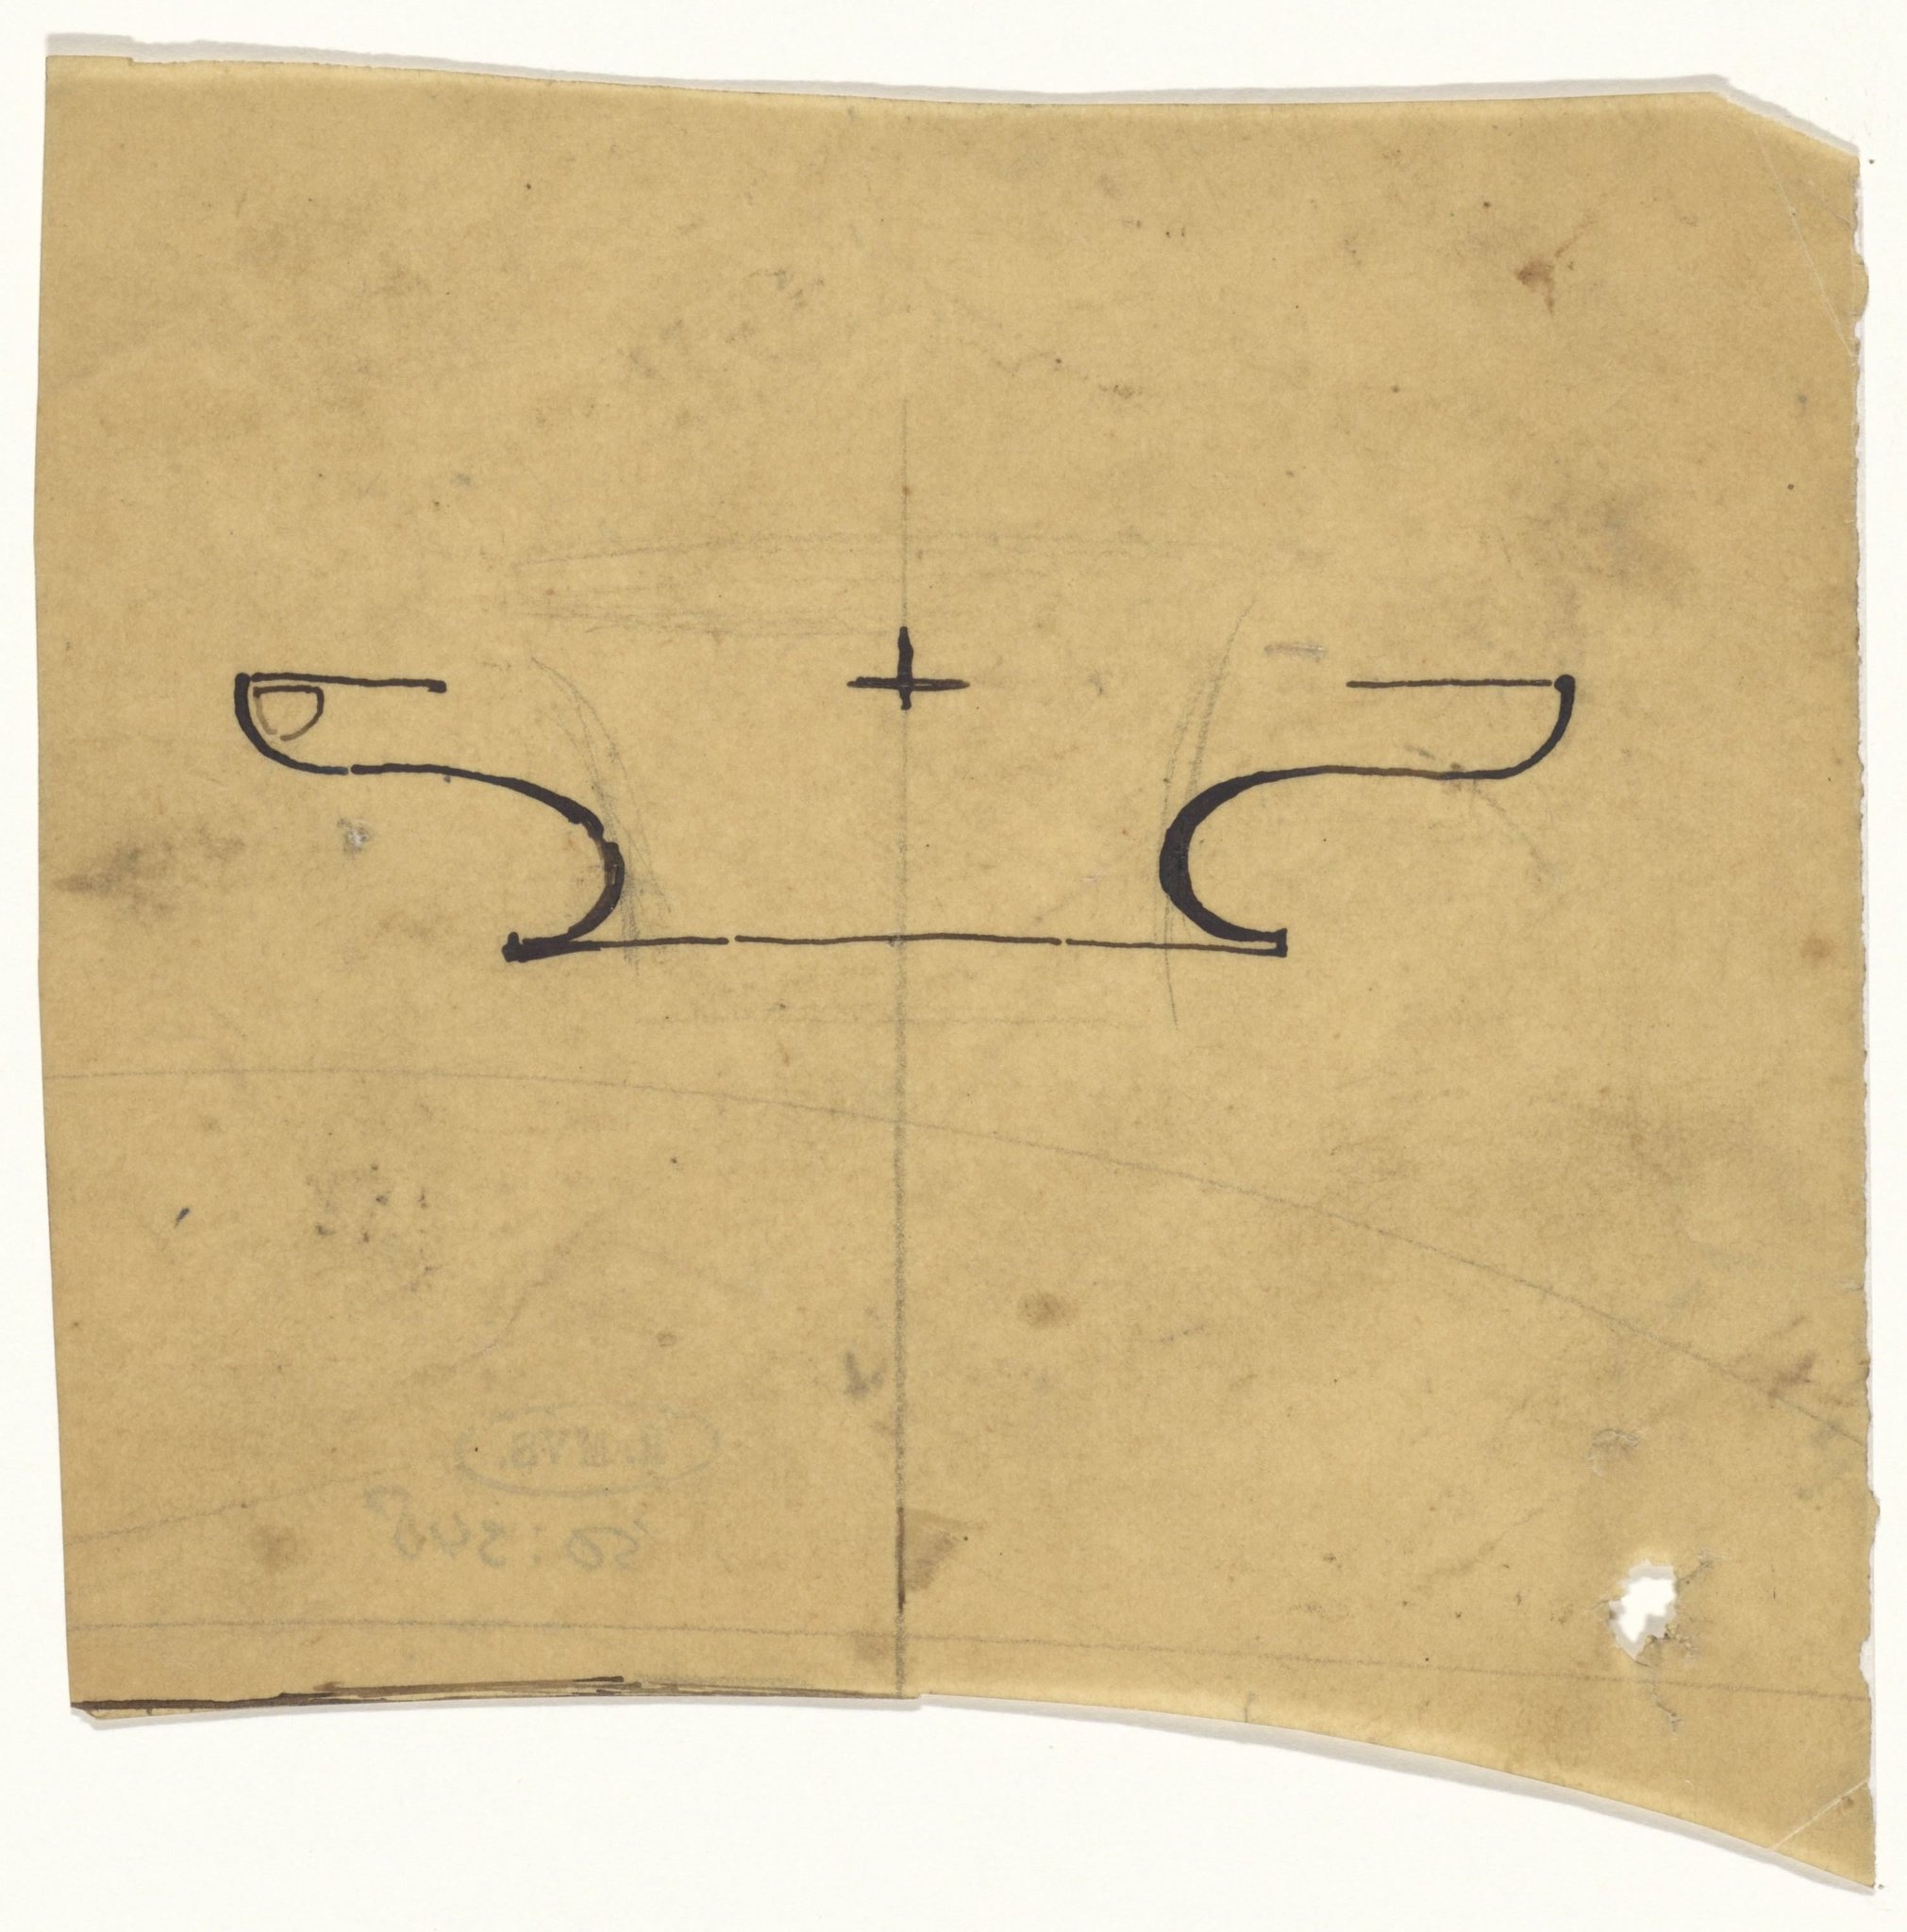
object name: design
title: Ontwerp voor zout- en pepervaten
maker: mathieu lauweriks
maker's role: designer, draughtsman, print maker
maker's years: 1864-1932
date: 1874-1932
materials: ink, pencil, paper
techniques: pen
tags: spice-box, salt-cellar, salt-shaker